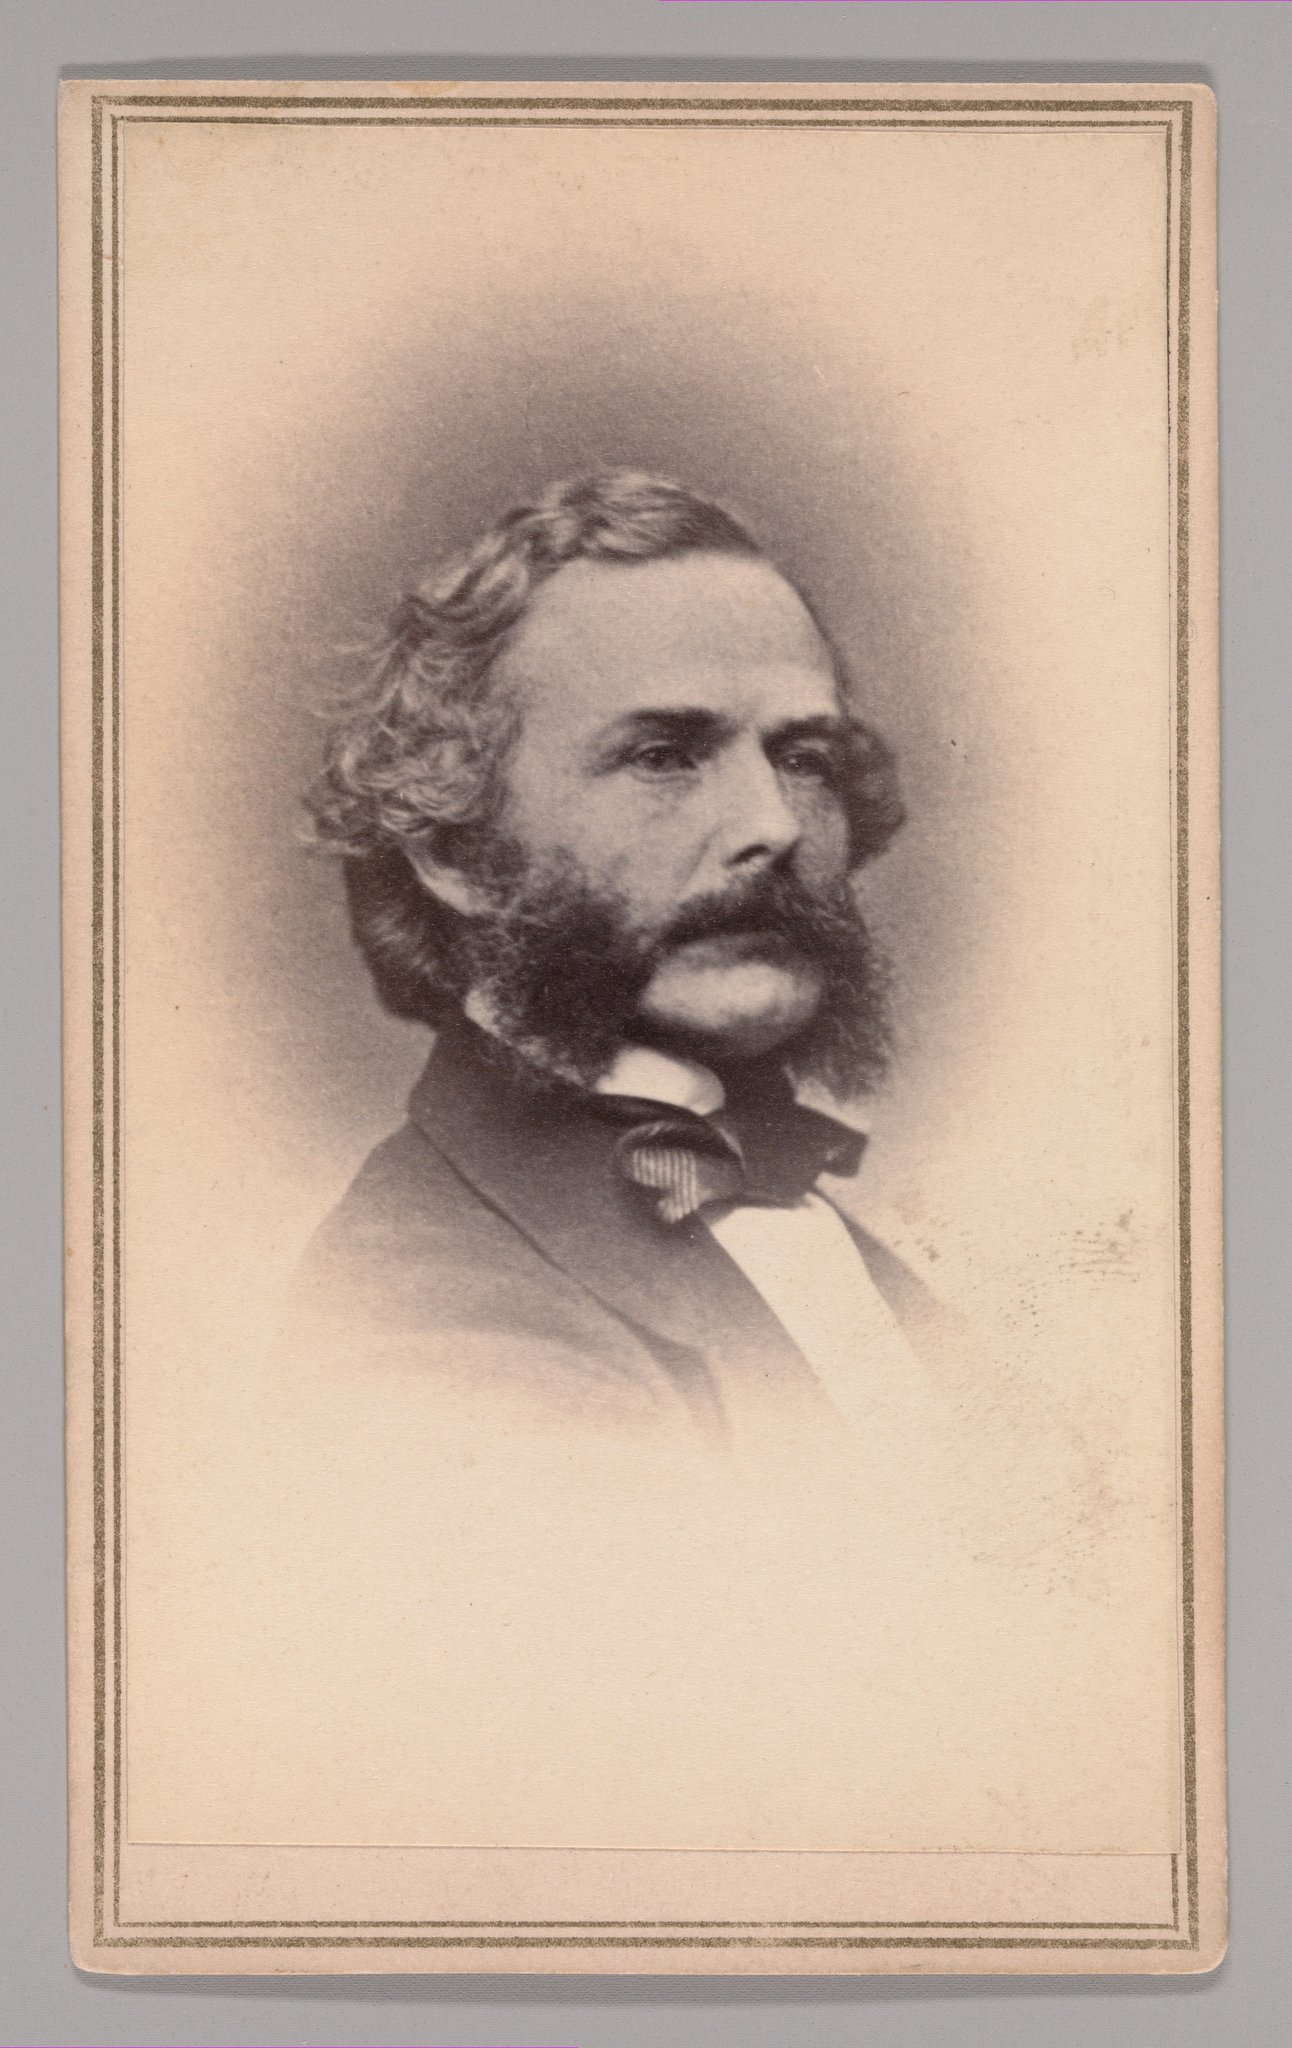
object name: carte de visite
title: [Unknown Sitter]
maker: Anonymous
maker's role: artist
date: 1860-1869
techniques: albumen silver print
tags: men,portraits